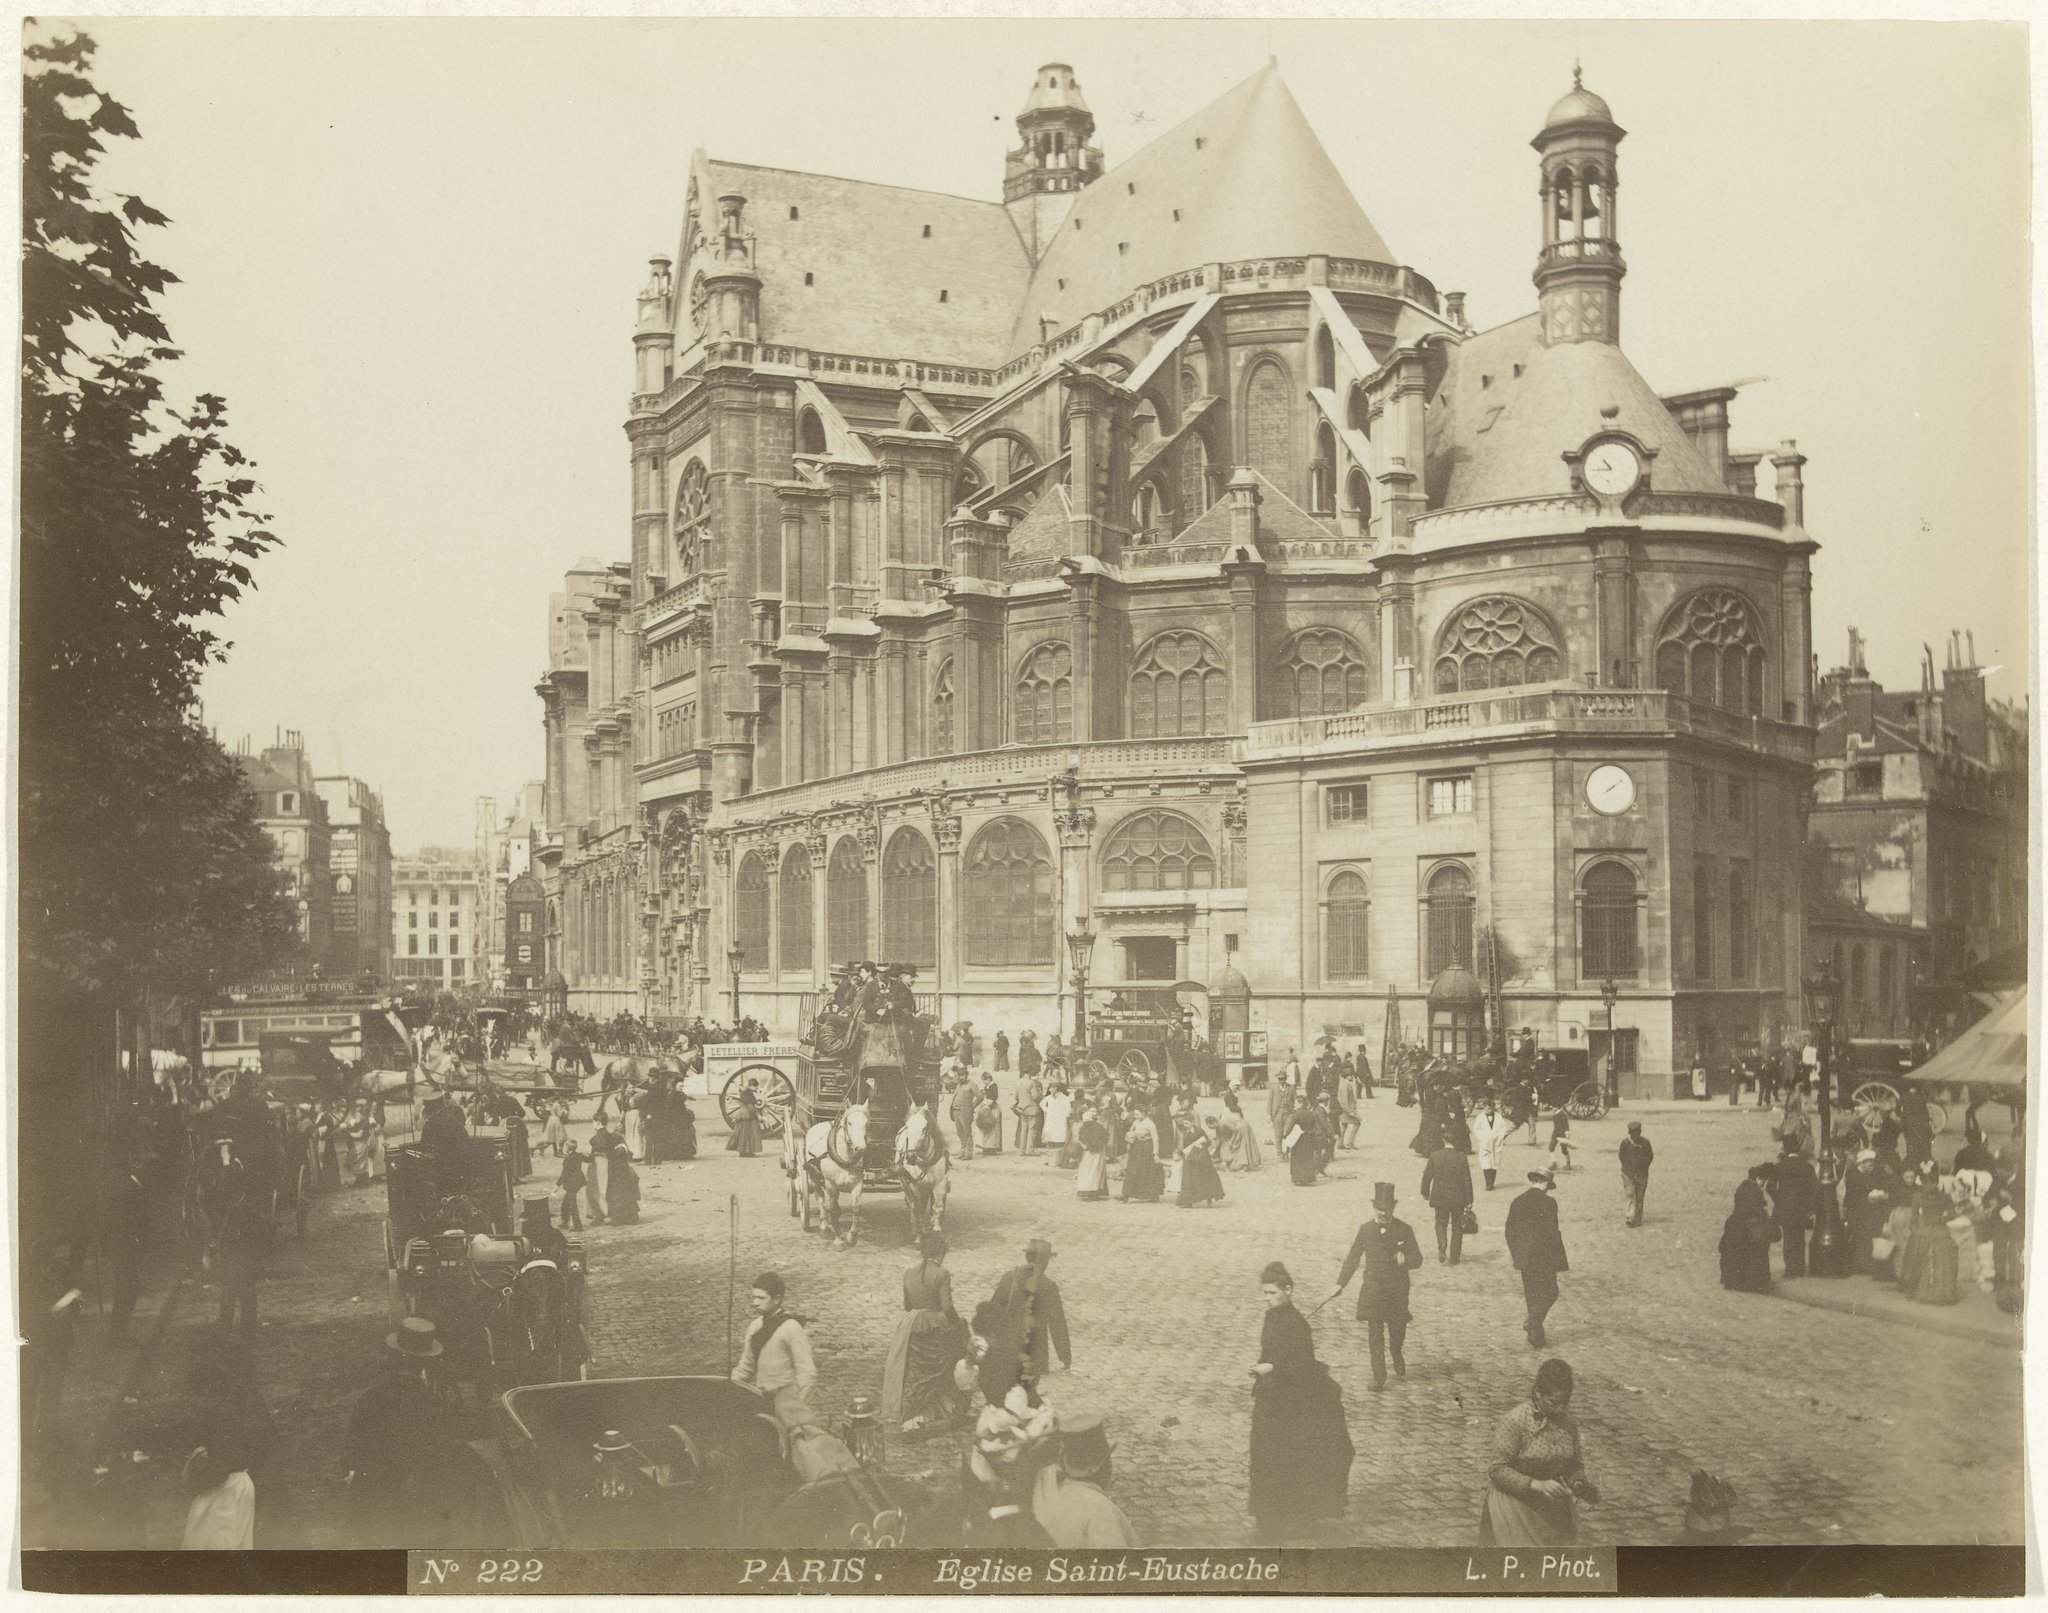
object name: photograph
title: Exterieur van de Saint-Eustache te Parijs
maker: louis antoine pamard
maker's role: fotograaf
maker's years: 1840-1893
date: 1870-1900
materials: cardboard, paper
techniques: albumen print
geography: paris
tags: square, place, circus, etc., church (exterior)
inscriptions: number: ‘14’, number: ‘No. 222’